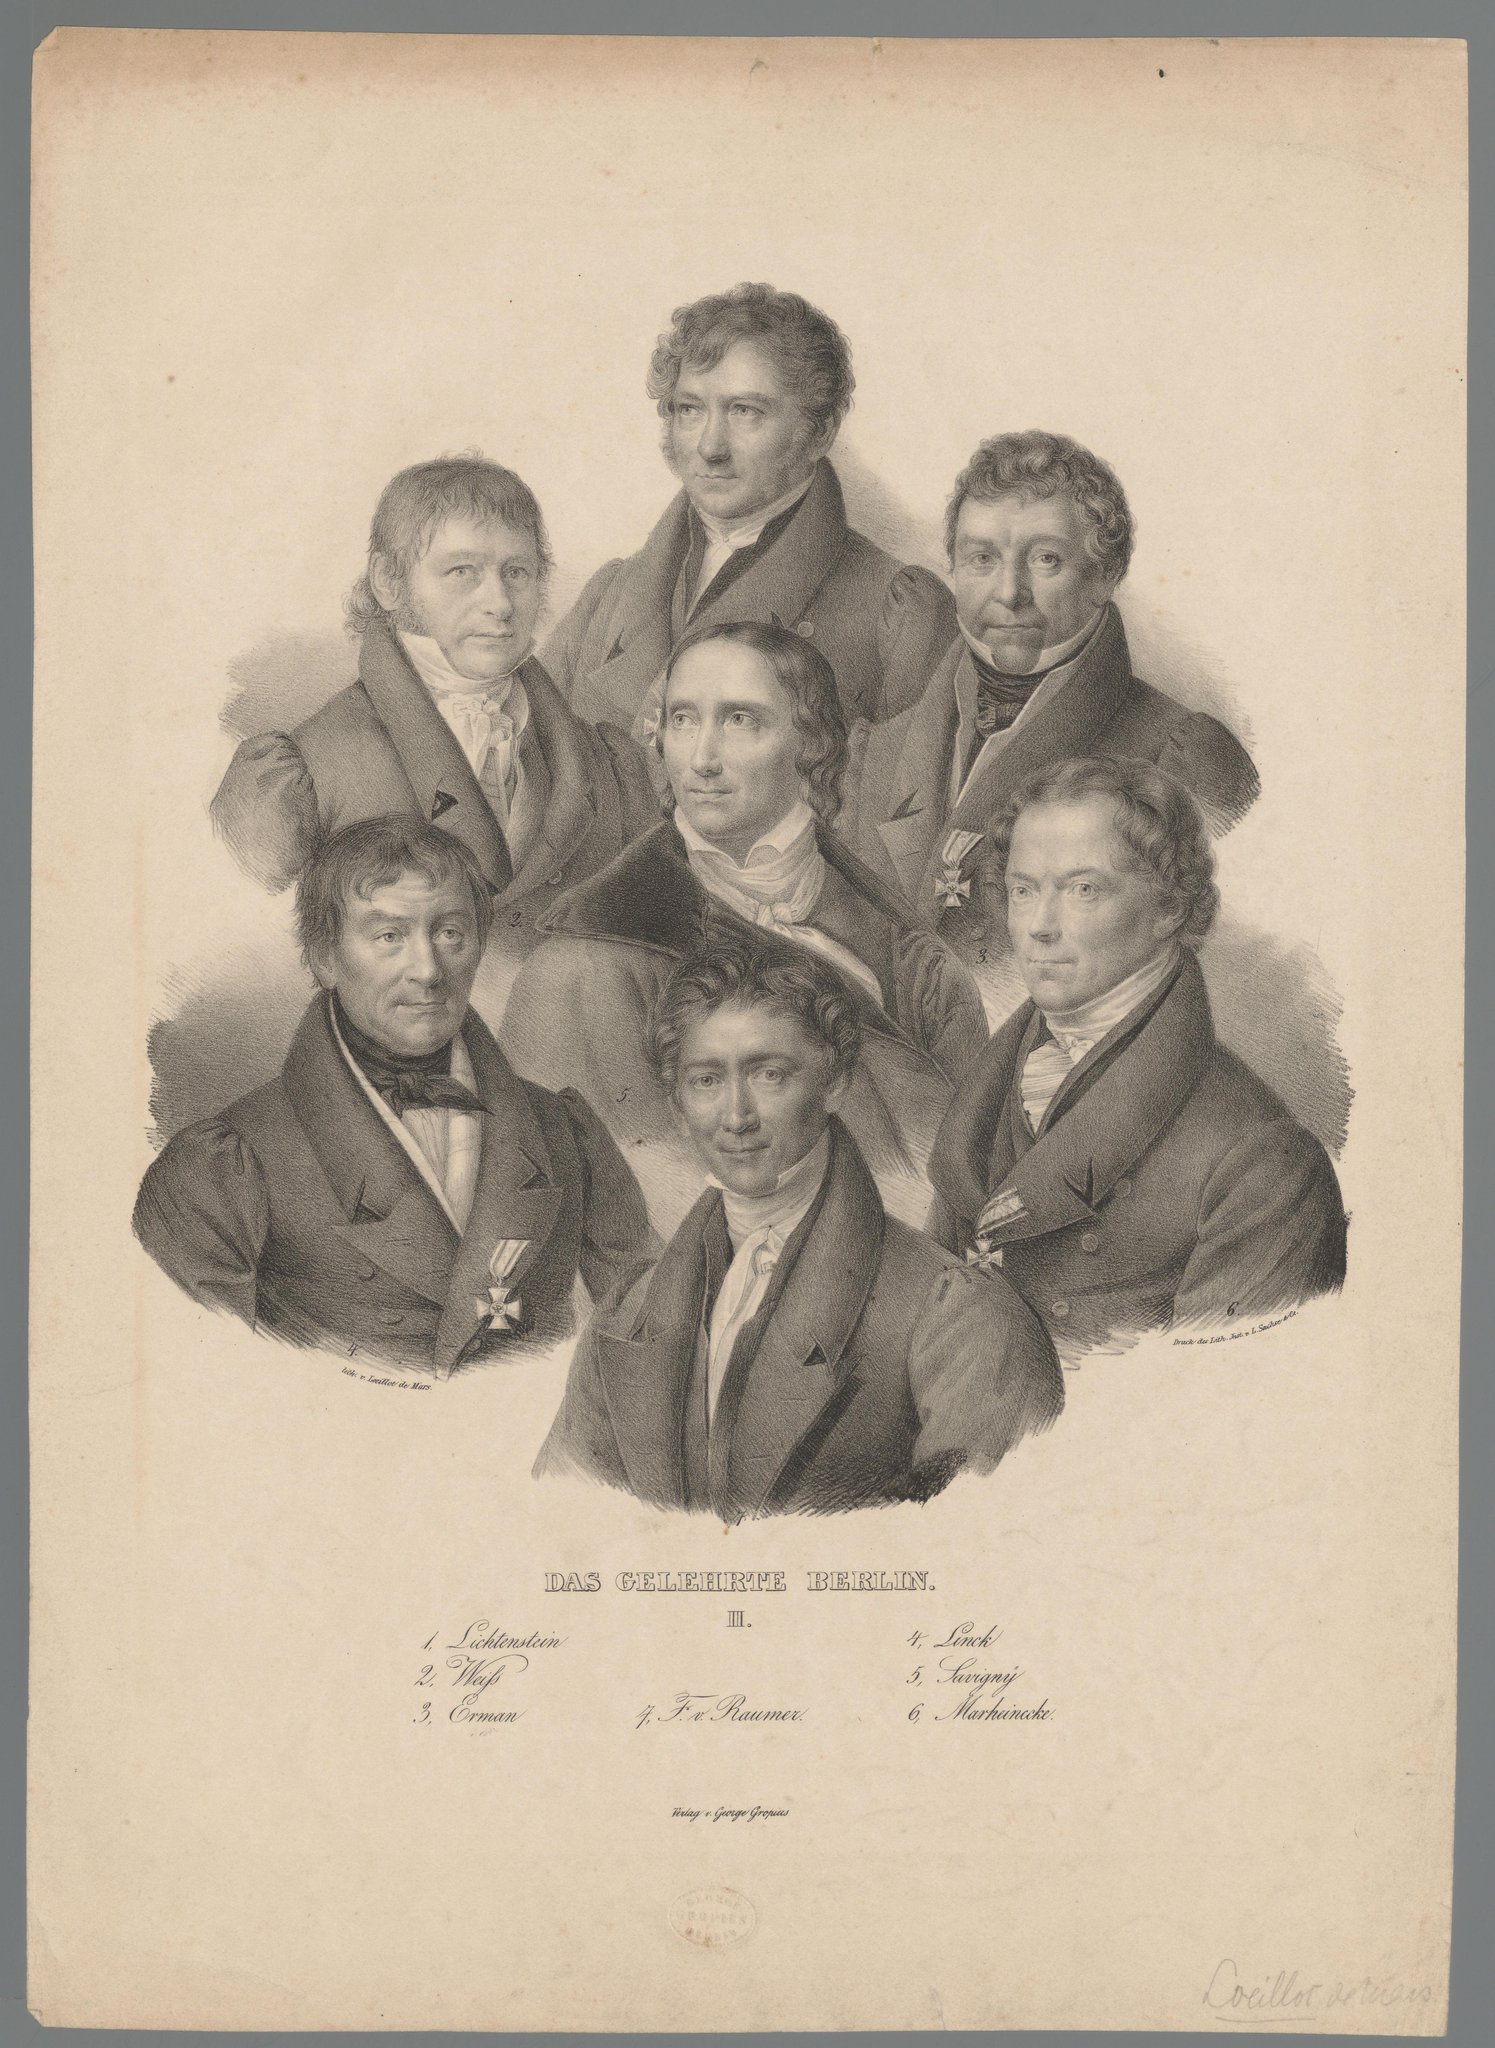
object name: print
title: Portretten van zeven Berlijnse geleerden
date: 1832-1871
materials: paper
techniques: lithograph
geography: berlin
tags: berlin, friedrich von raumer, minister ~ government, theologian, scholar, philosopher, zoology (+ portrait of scholar, scientist), historical persons, physician, doctor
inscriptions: collector's mark: Lugt 2228, check stamp: Lugt 4607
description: Portretten van geleerden met de namen Martin Hinrich Lichtenstein, Christian Samuel Weiss, Paul Erman, Heinrich Friedrich Link, Friedrich Carl von Savigny, Philipp Conrad Marheineke en Friedrich von Raumer.